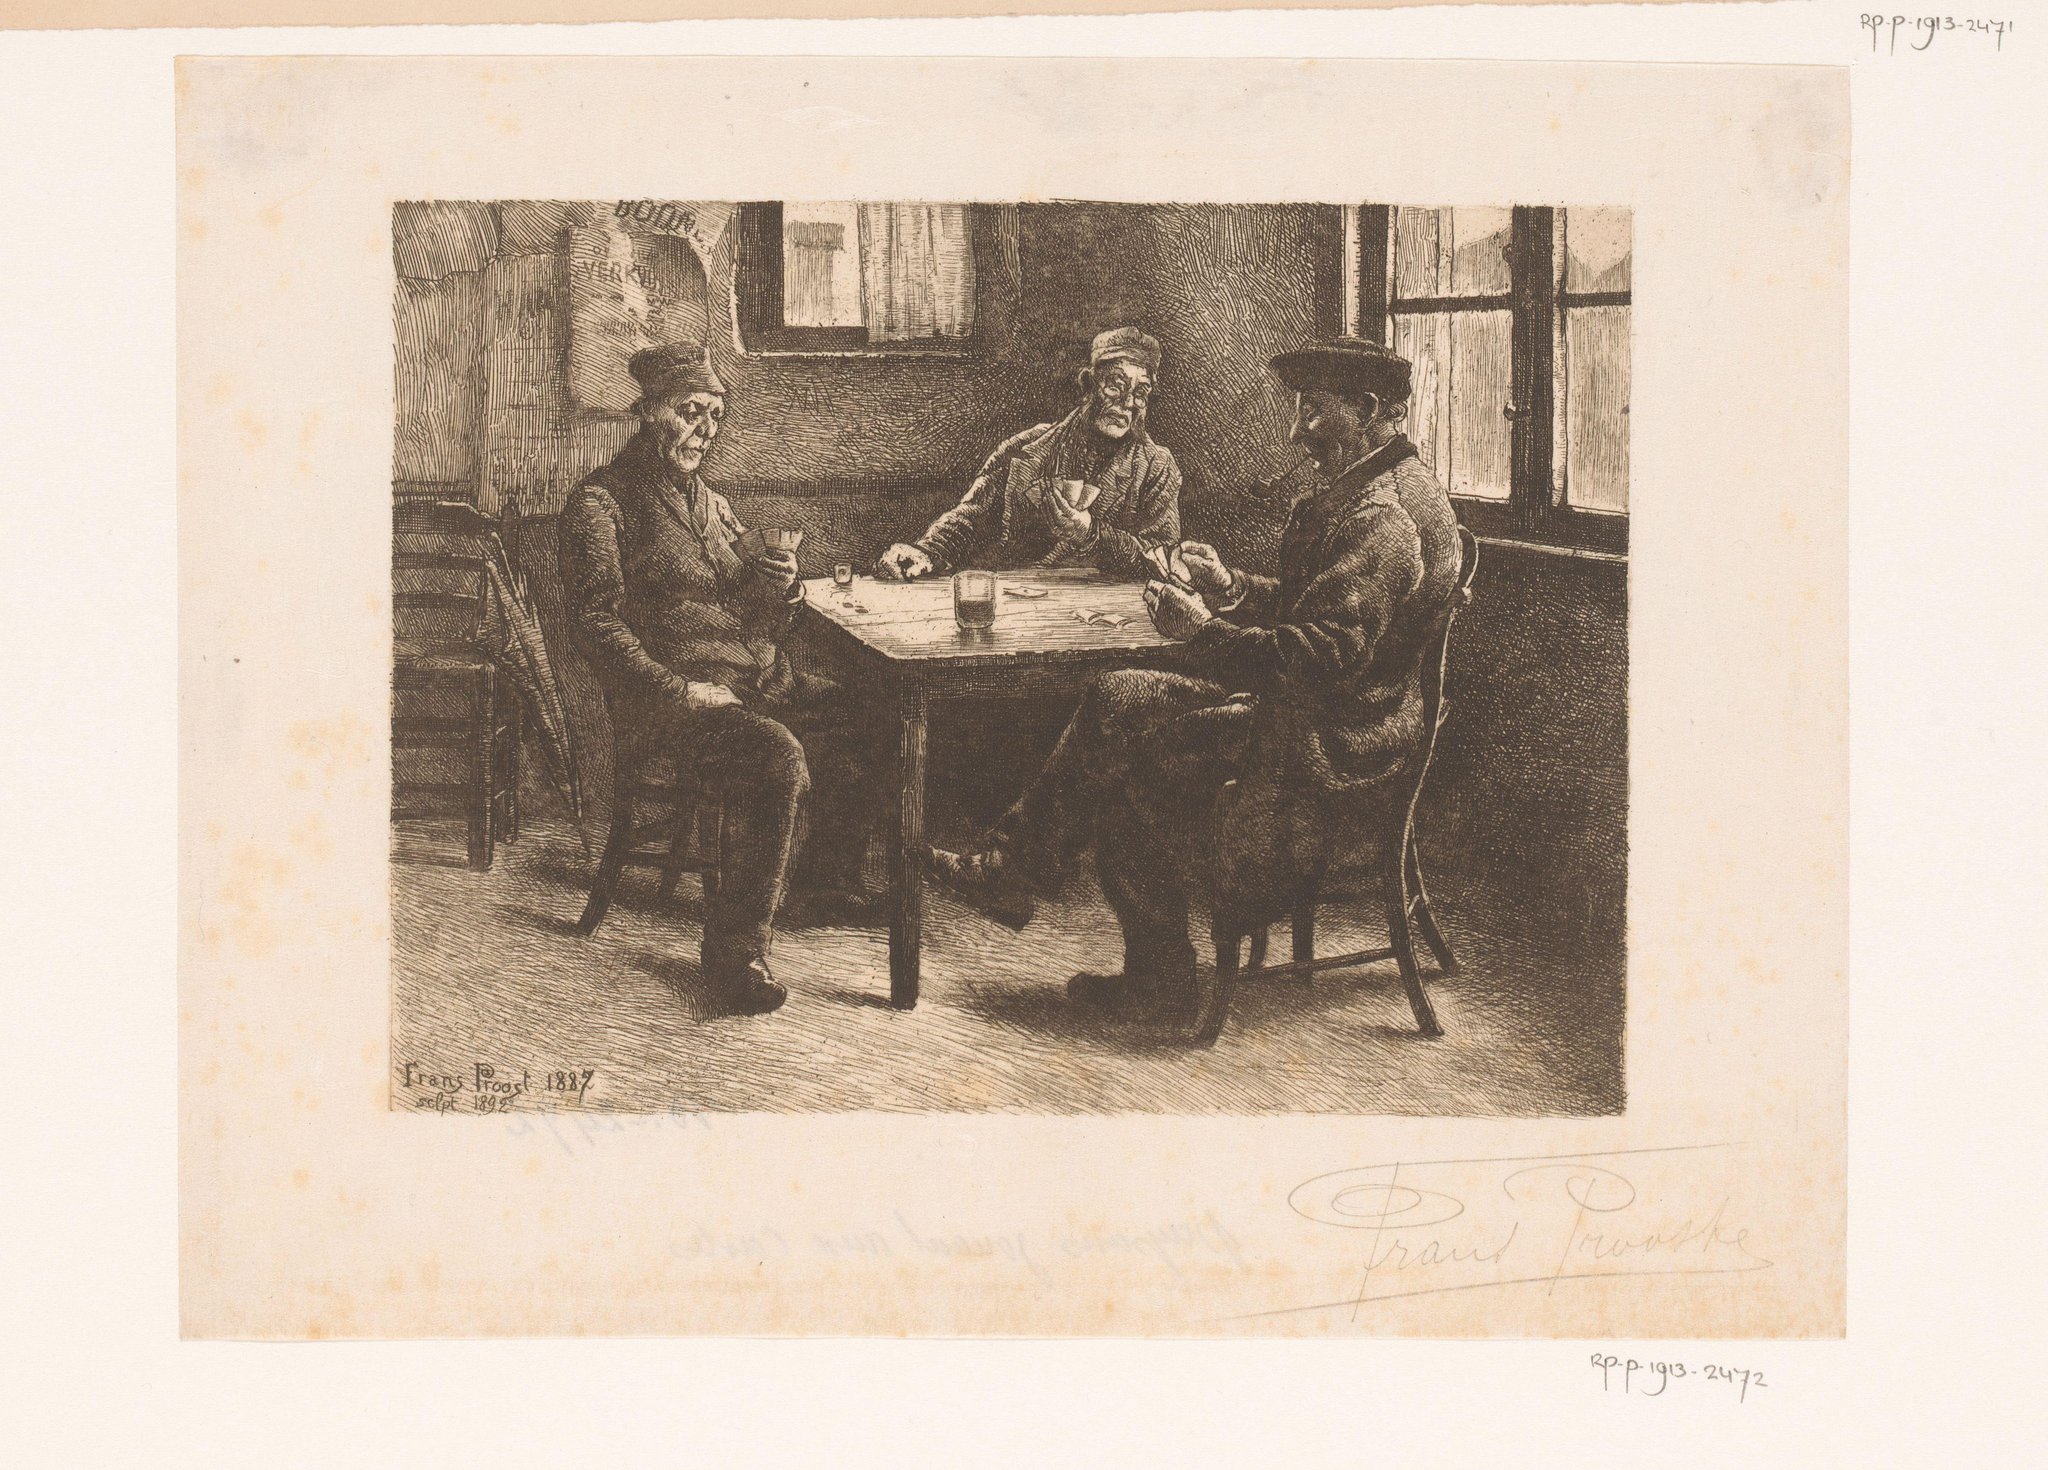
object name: print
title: Drie kaartende mannen in een café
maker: frans proost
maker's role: painter, print maker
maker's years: 1875-1941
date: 1887-1892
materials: paper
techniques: etching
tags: inn, coffee-house, public house, etc., card games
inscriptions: collector's mark: Lugt 2228